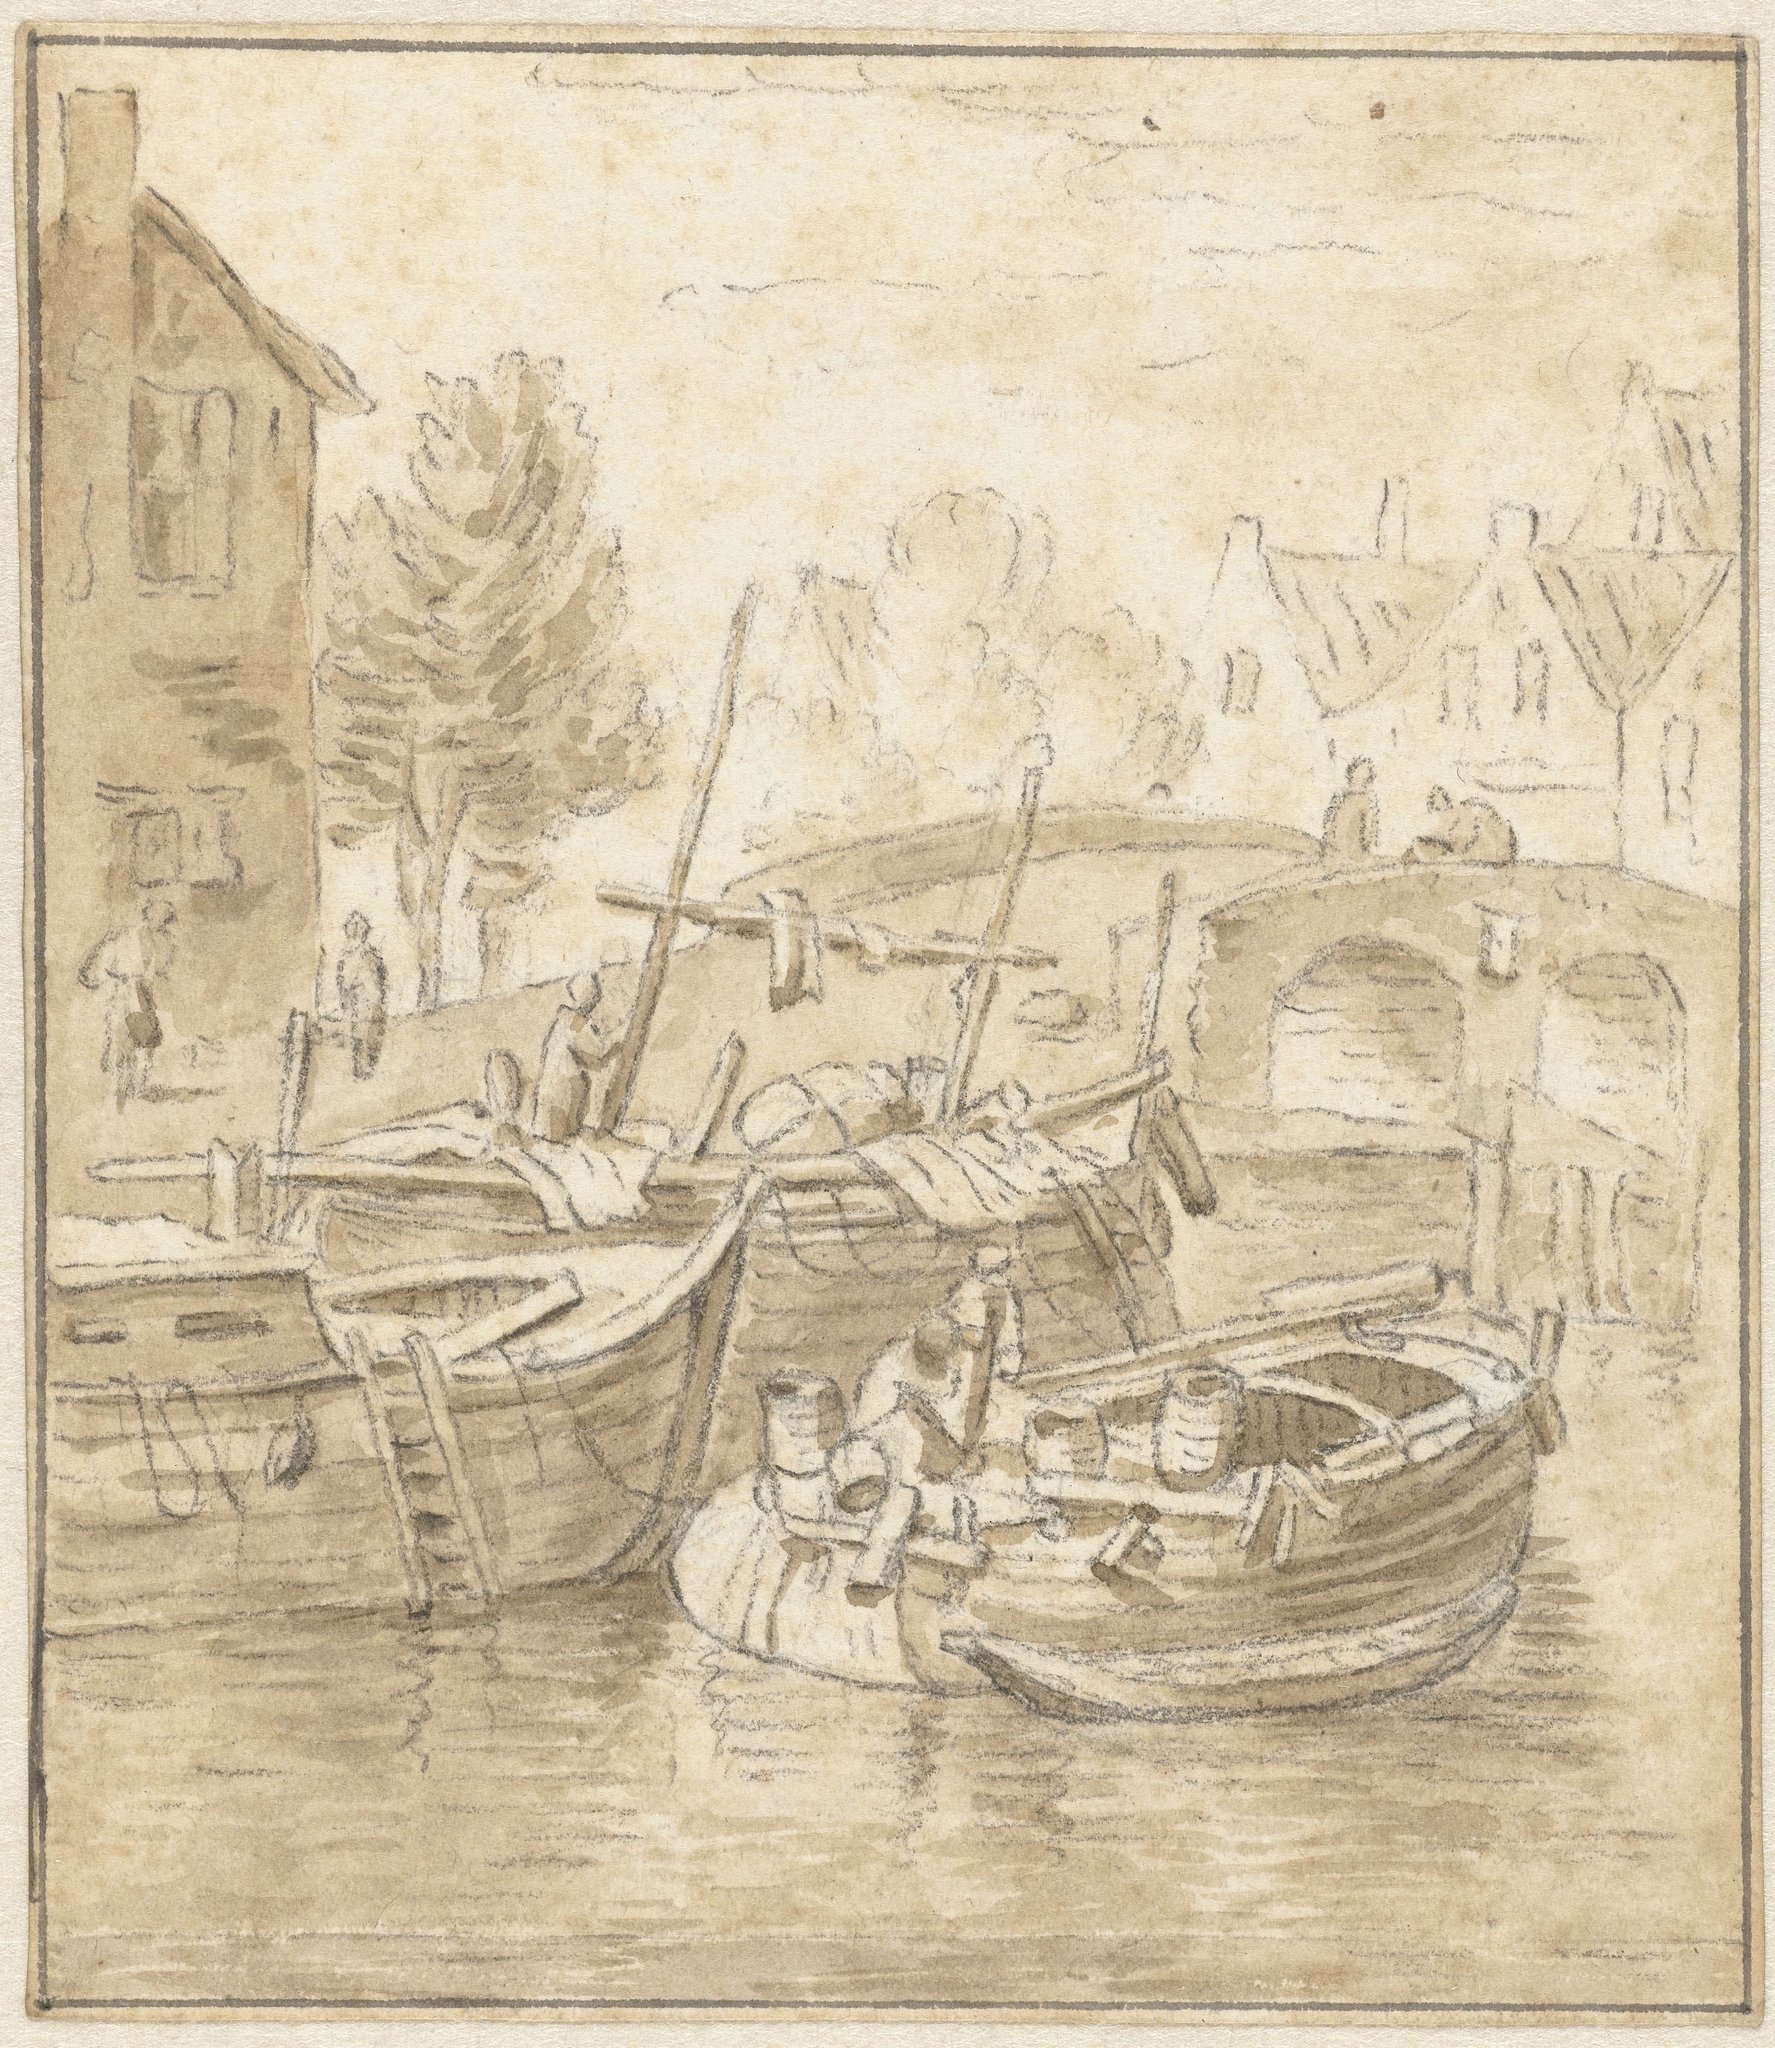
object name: drawing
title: Schepen bij een brug in een stad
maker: jacob de vos (1735-1833)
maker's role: draughtsman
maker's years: 1735-1833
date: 1814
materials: paper, pencil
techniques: brush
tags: ships (in general), village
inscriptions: inscription: ‘Jb de Vos jbZ / Ft 1814: na / H. Saftleven’